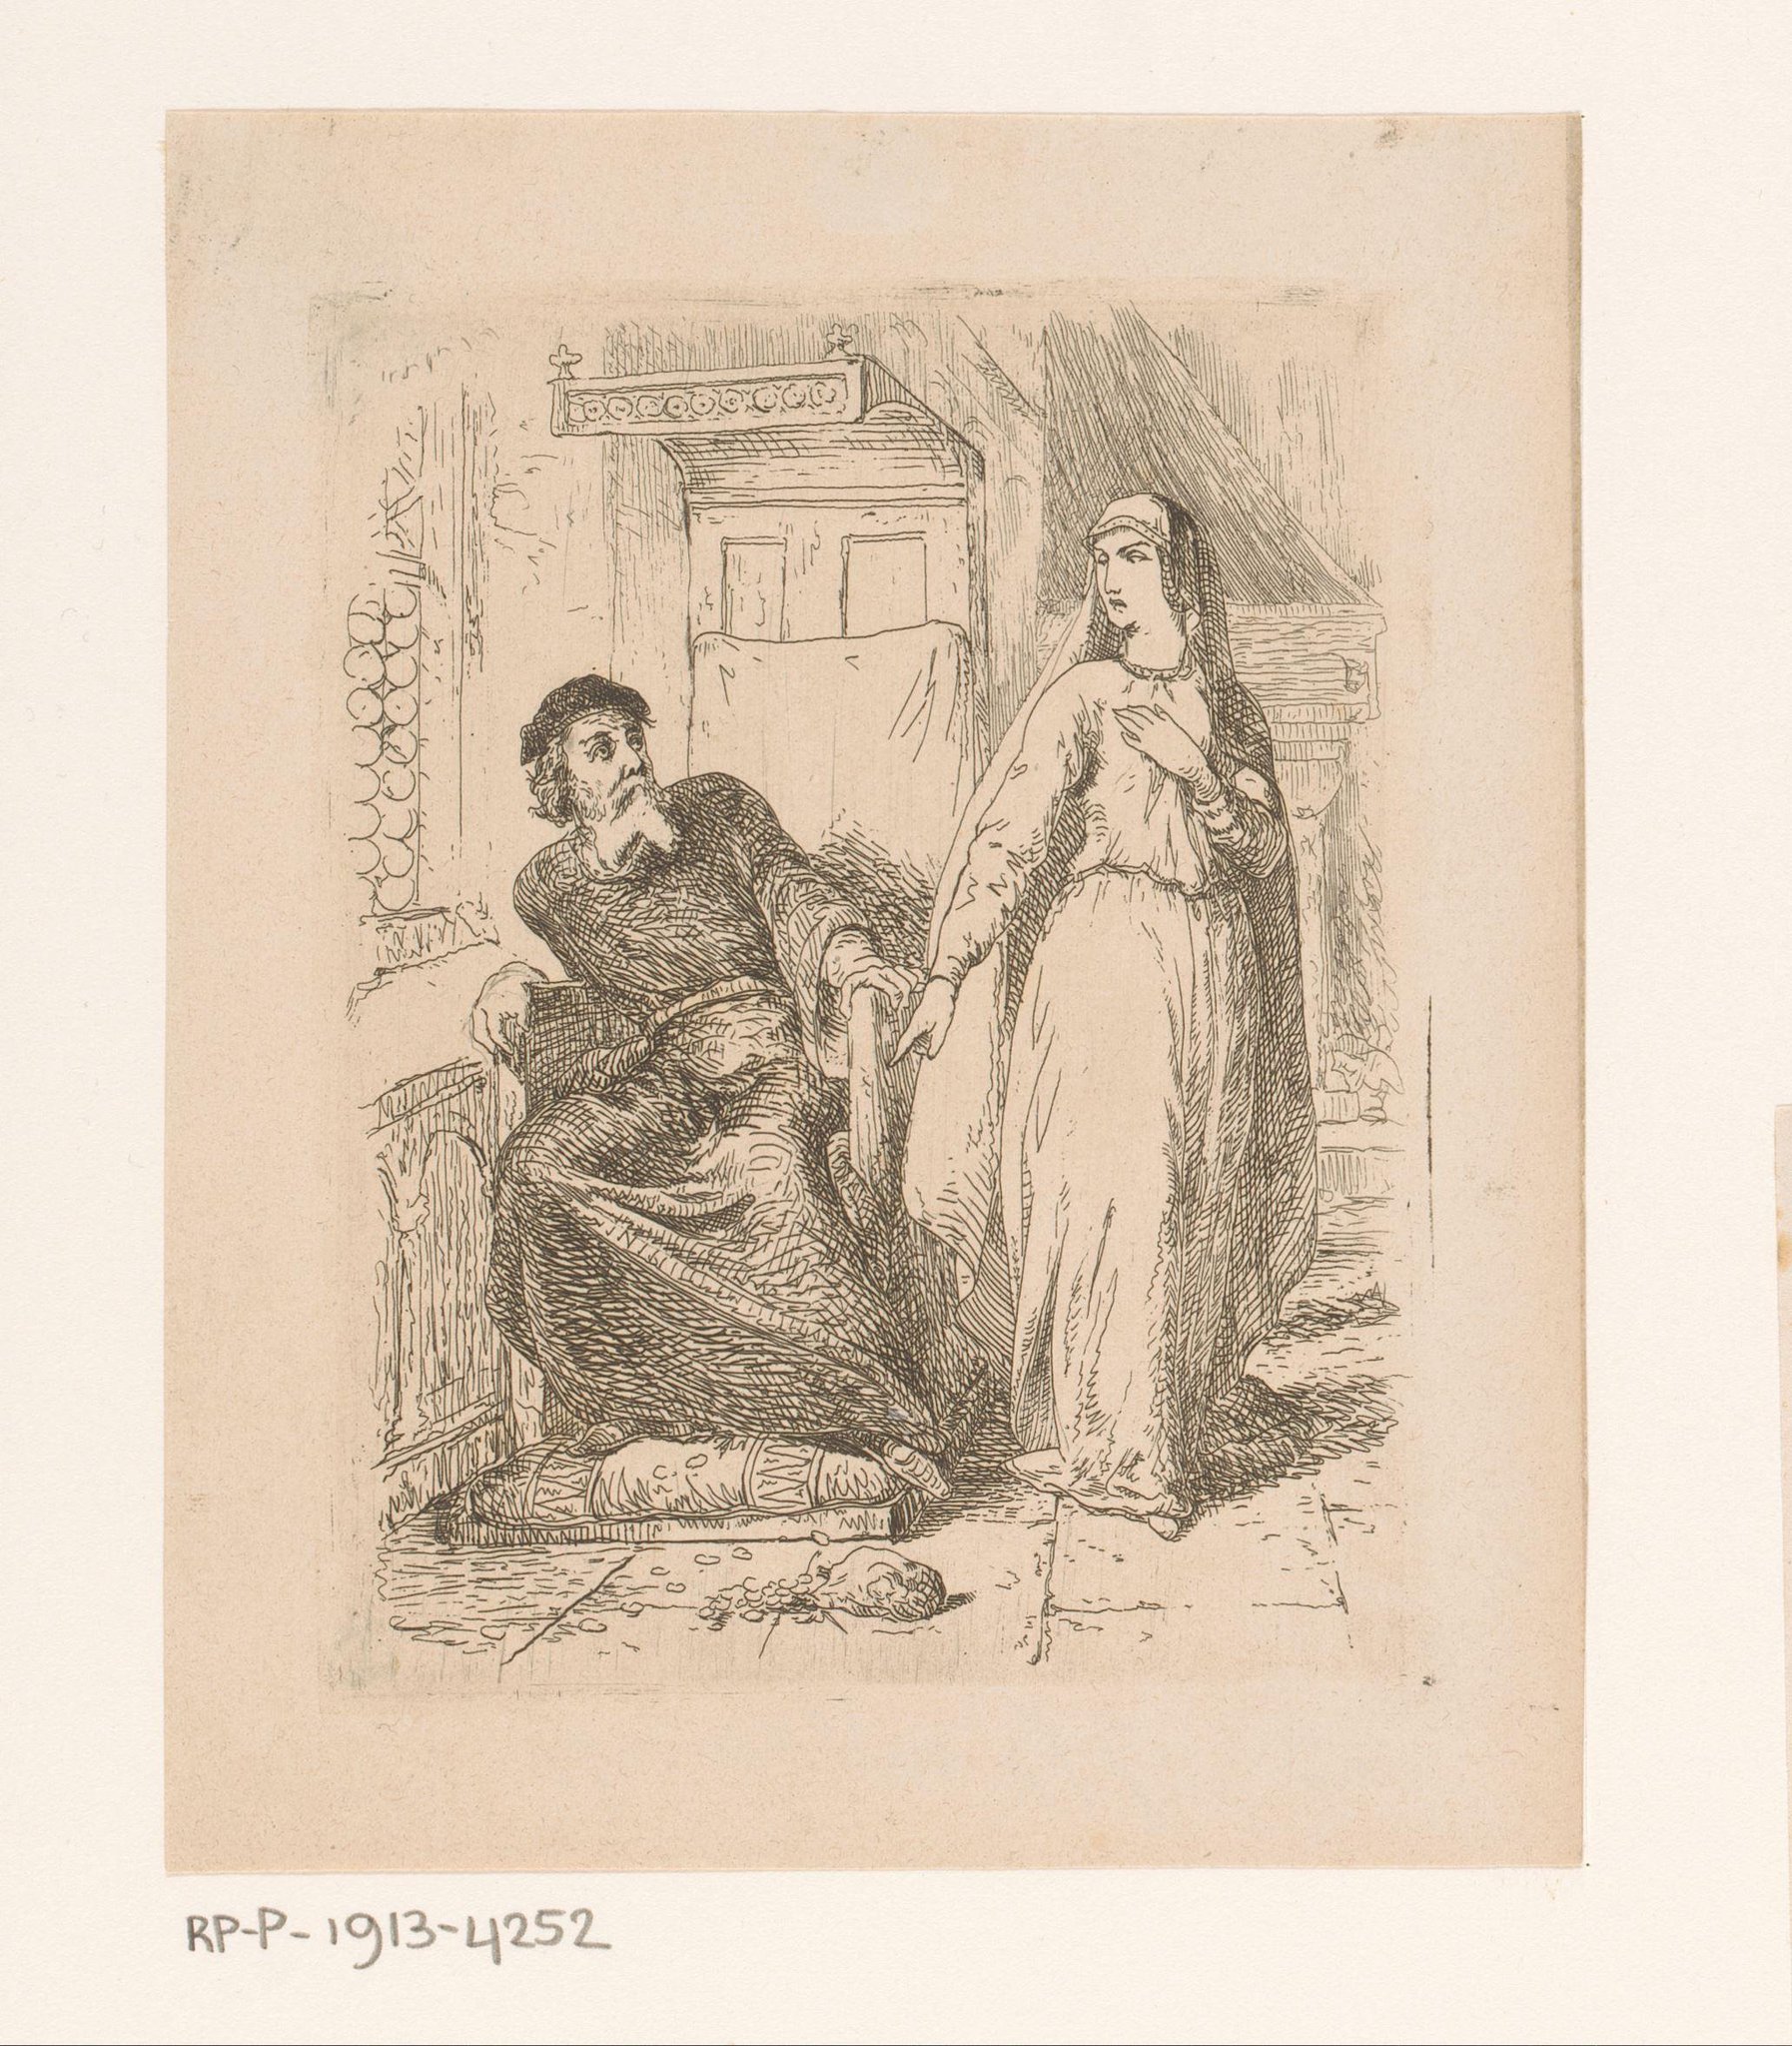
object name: book illustration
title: Bruno en zijn dochter Laura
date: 1857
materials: paper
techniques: etching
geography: amsterdam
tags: dowry, widow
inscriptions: collector's mark: Lugt 1485, collector's mark: Lugt 2228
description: Prent uit: Horst, J.J. van der. Vader Bruno, de kluizenaar van Overveen. Amsterdam: C.L. van Langenhuysen, 1857.